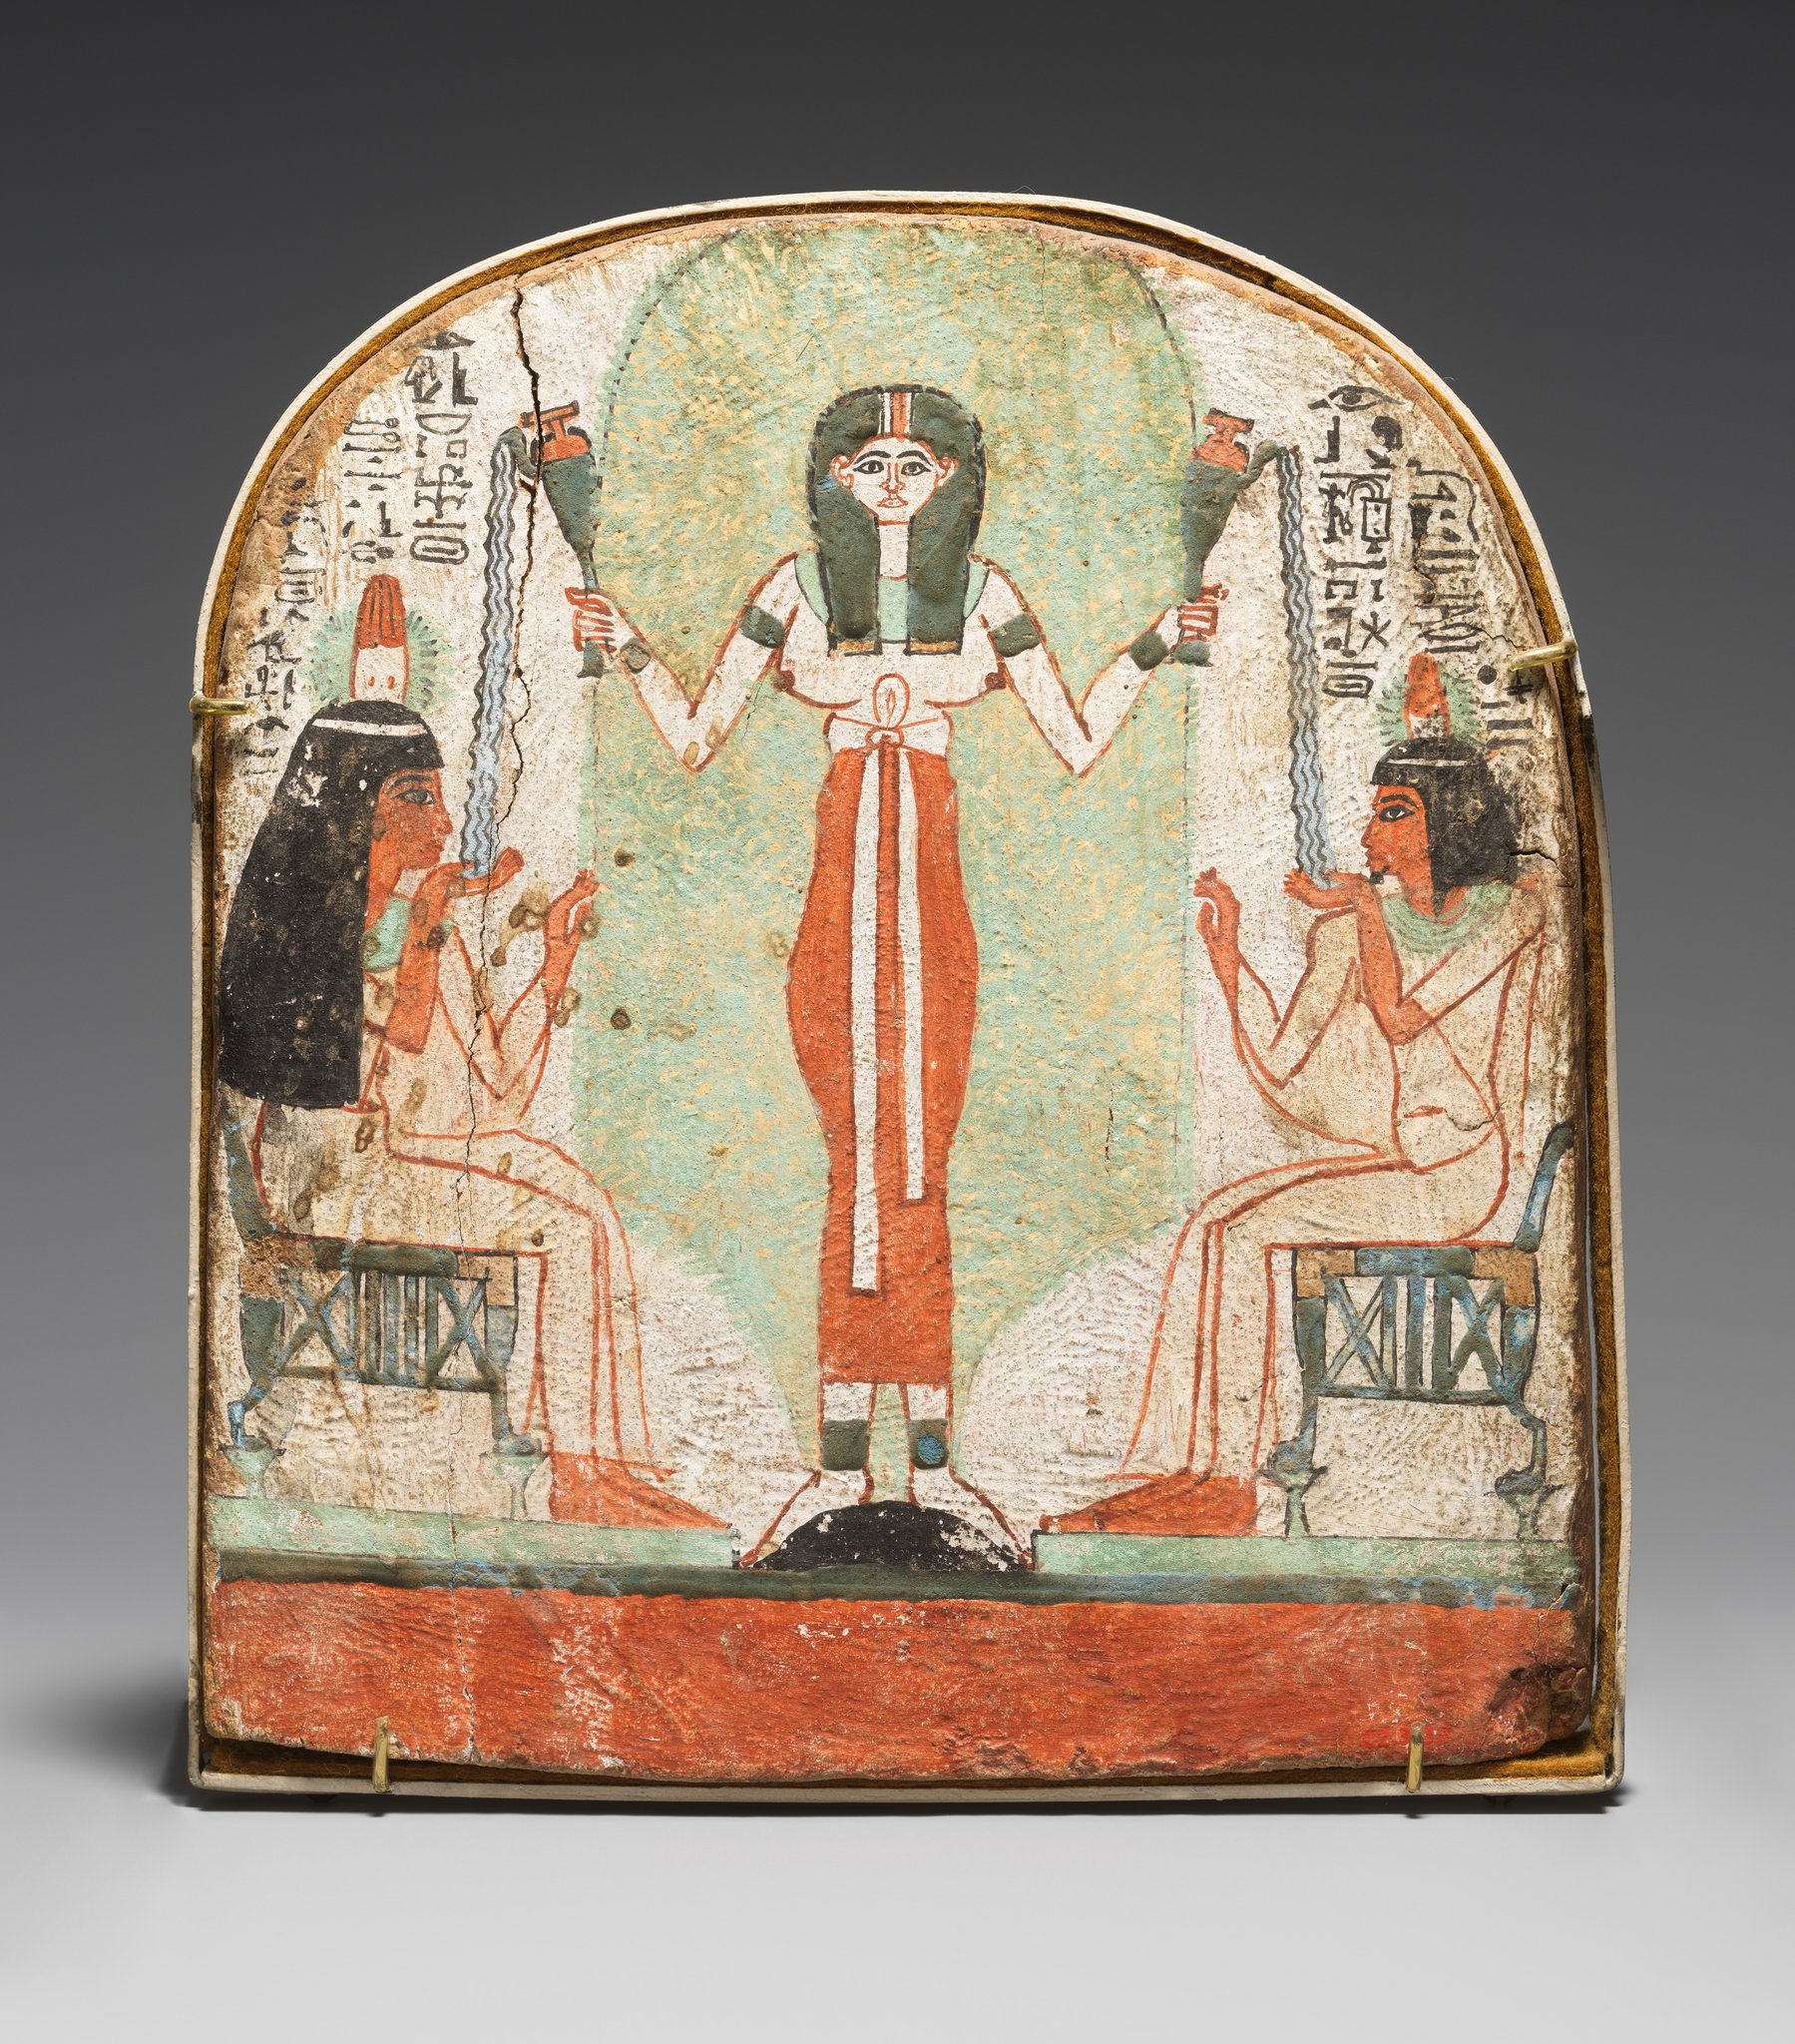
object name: stela, painted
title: Stela of Tjanetdinetiset and Djedbastet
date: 825-712 BCE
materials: paint, paste, wood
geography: egypt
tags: men,women